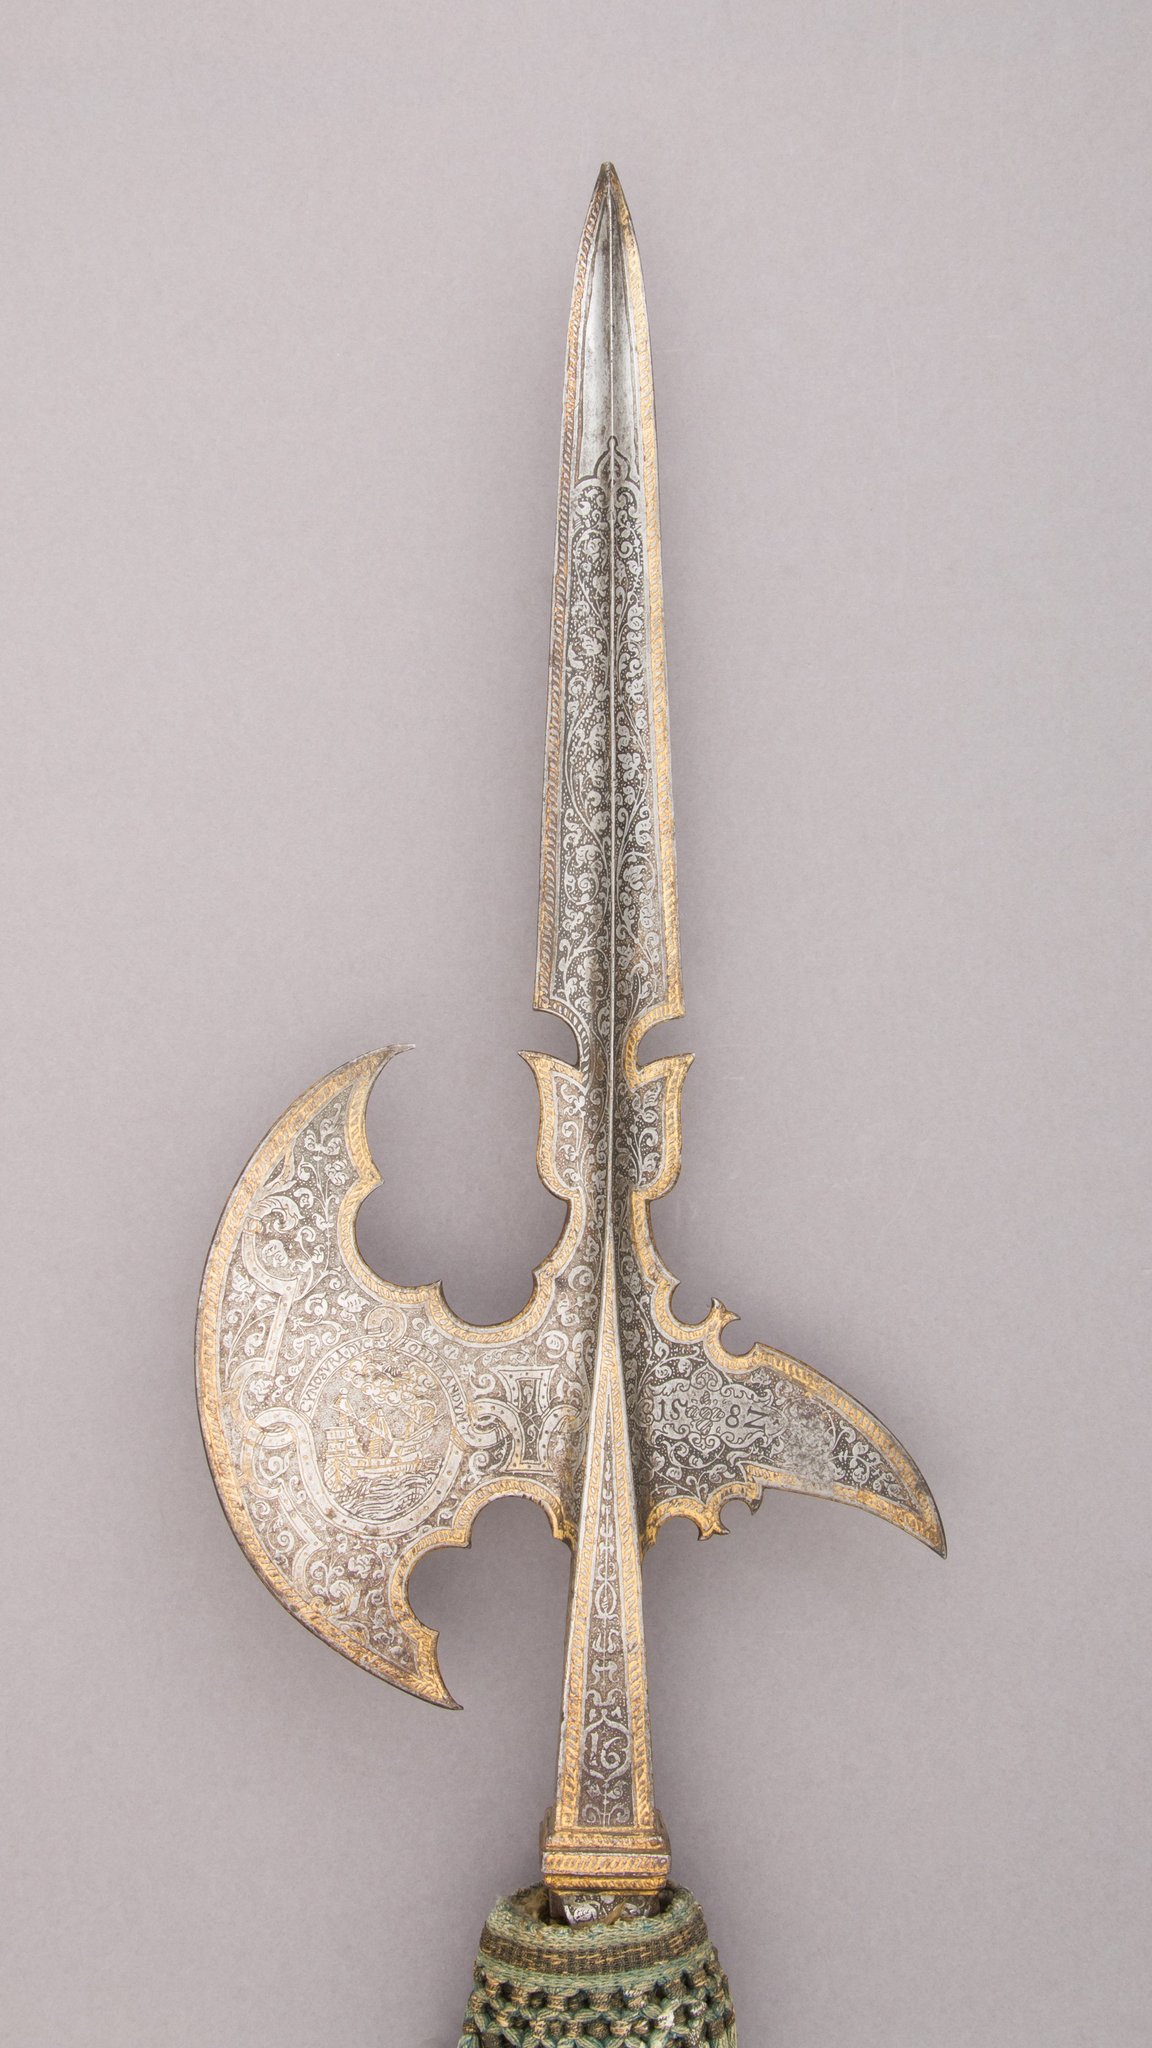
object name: halberd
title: Halberd with the Arms of William V, Duke of Bavaria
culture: german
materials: gold, metal thread, steel, textile, wood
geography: germany